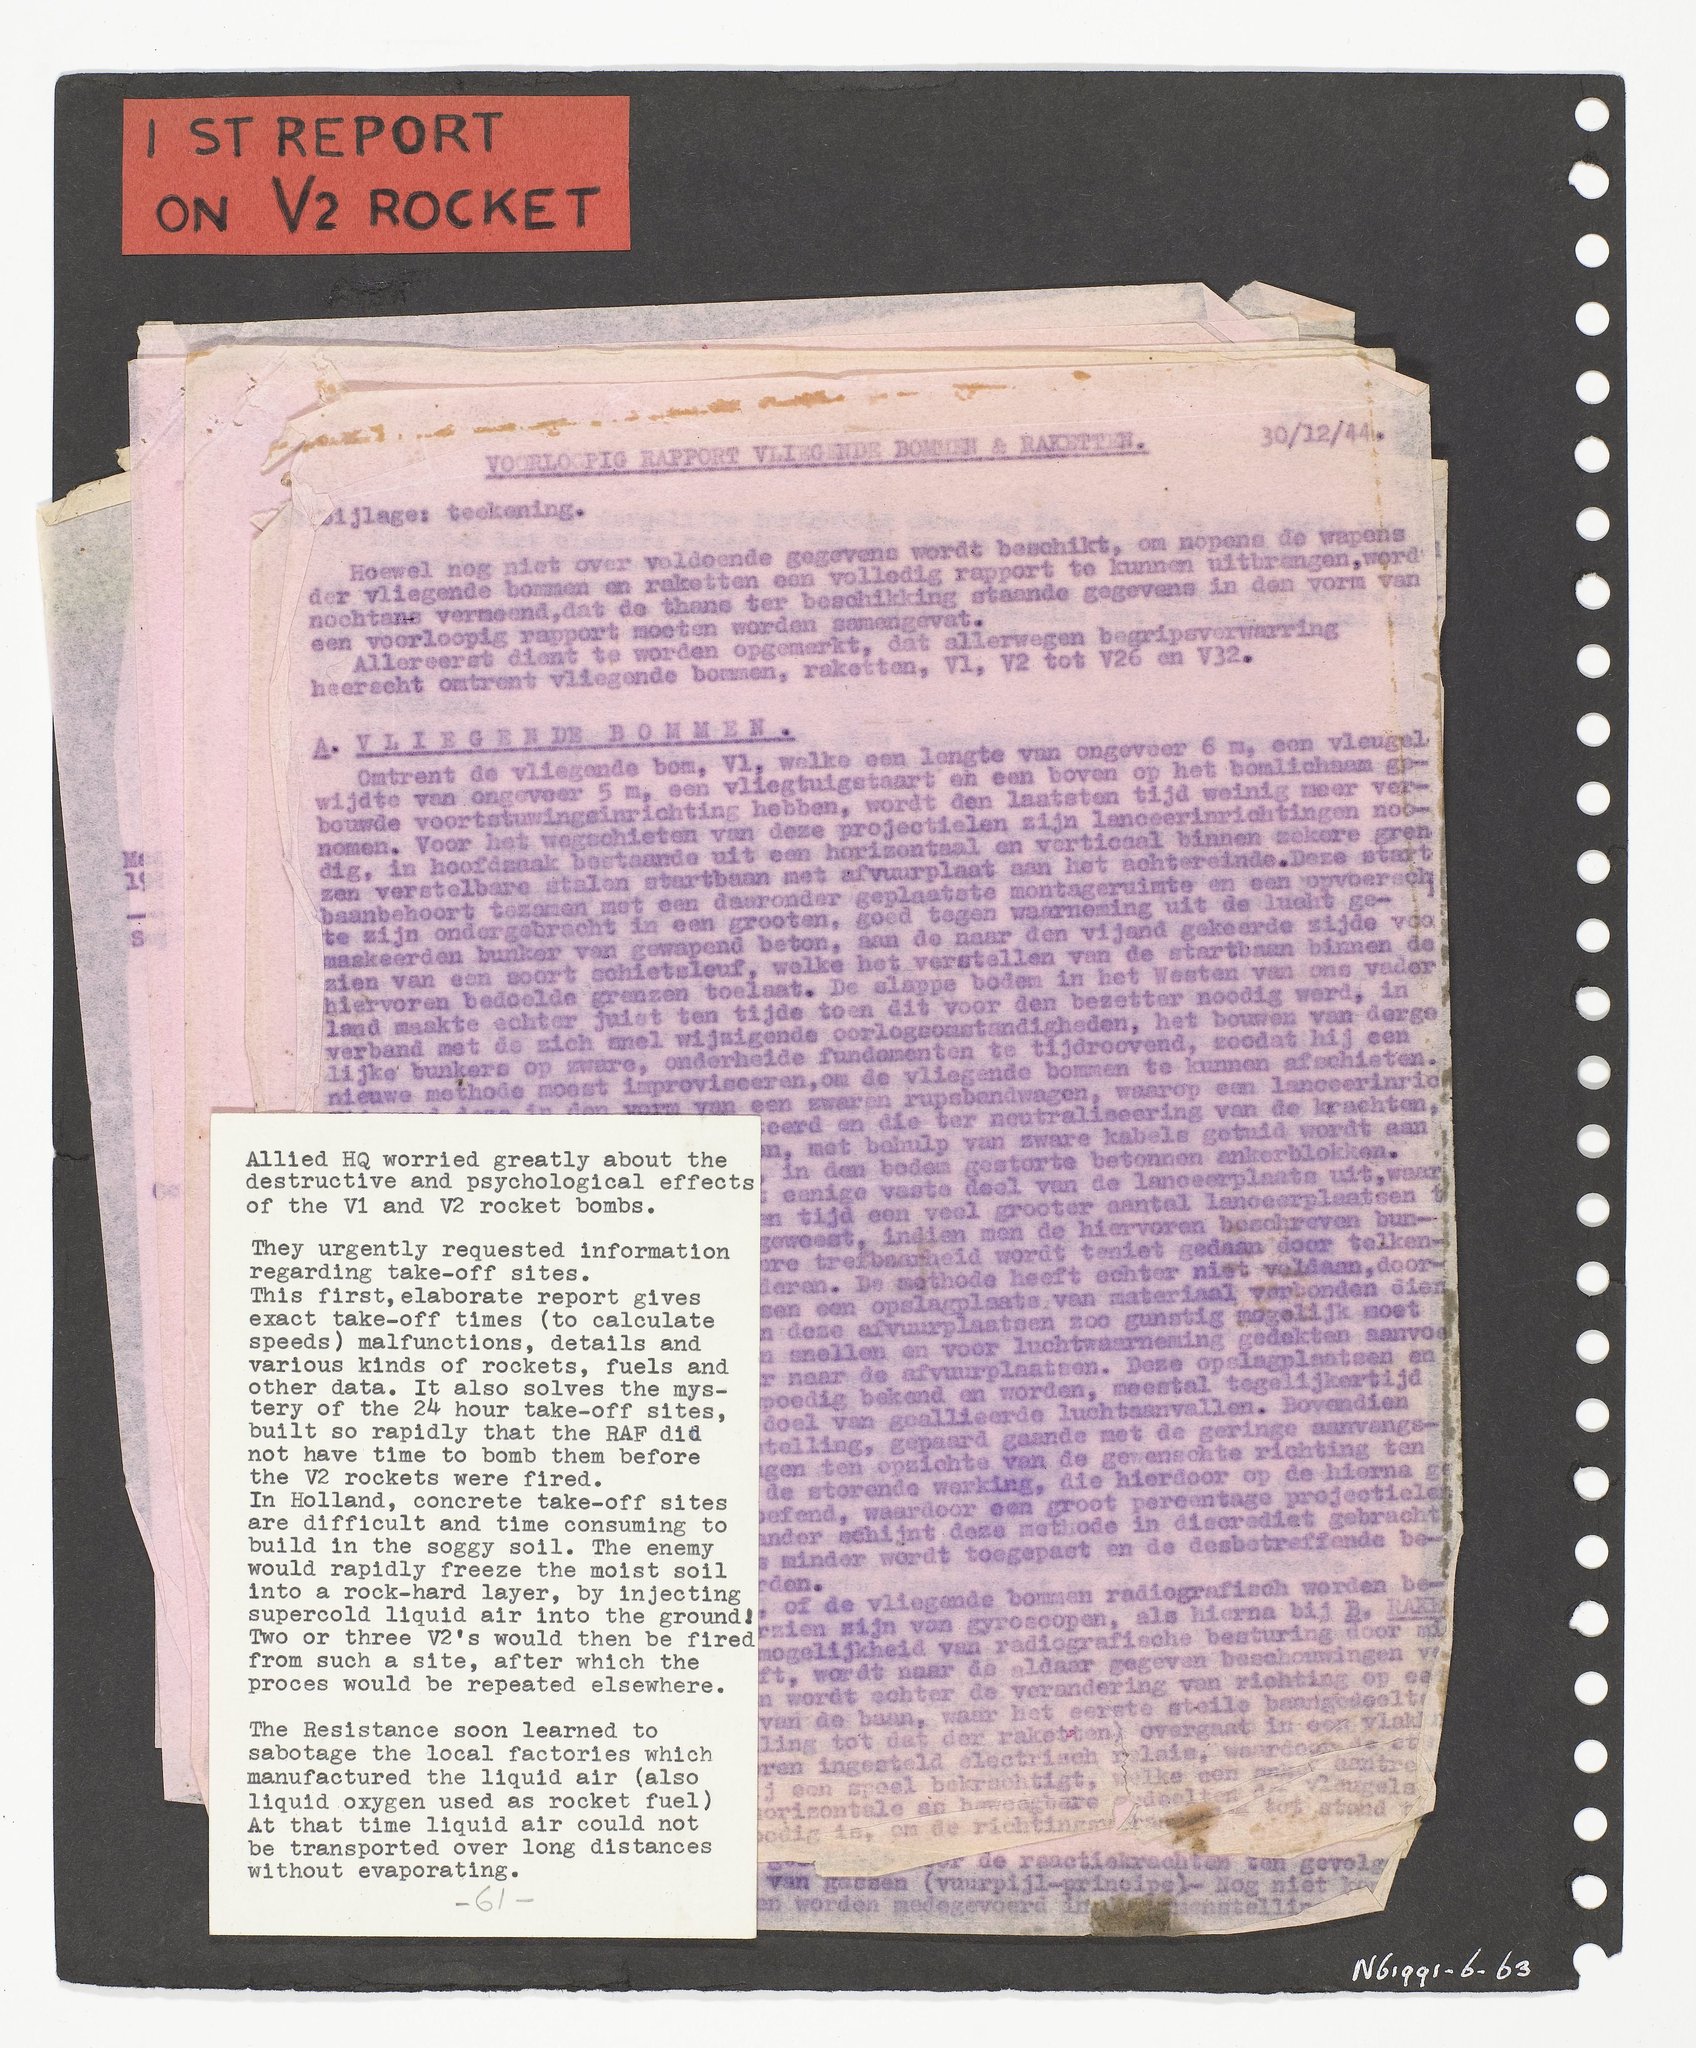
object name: album leaf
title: Foto en collageboek 'De Verborgen Camera'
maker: Anonymous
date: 1944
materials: paper, plastic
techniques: typewriting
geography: netherlands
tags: amsterdam, tonny van renterghem, fritz kahlenberg, underground movement, partisans, rocket (astronautics), projectiles, explosives, etc., netherlands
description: Rapport over vliegende bommen en raketten, voonamelijk de V2.